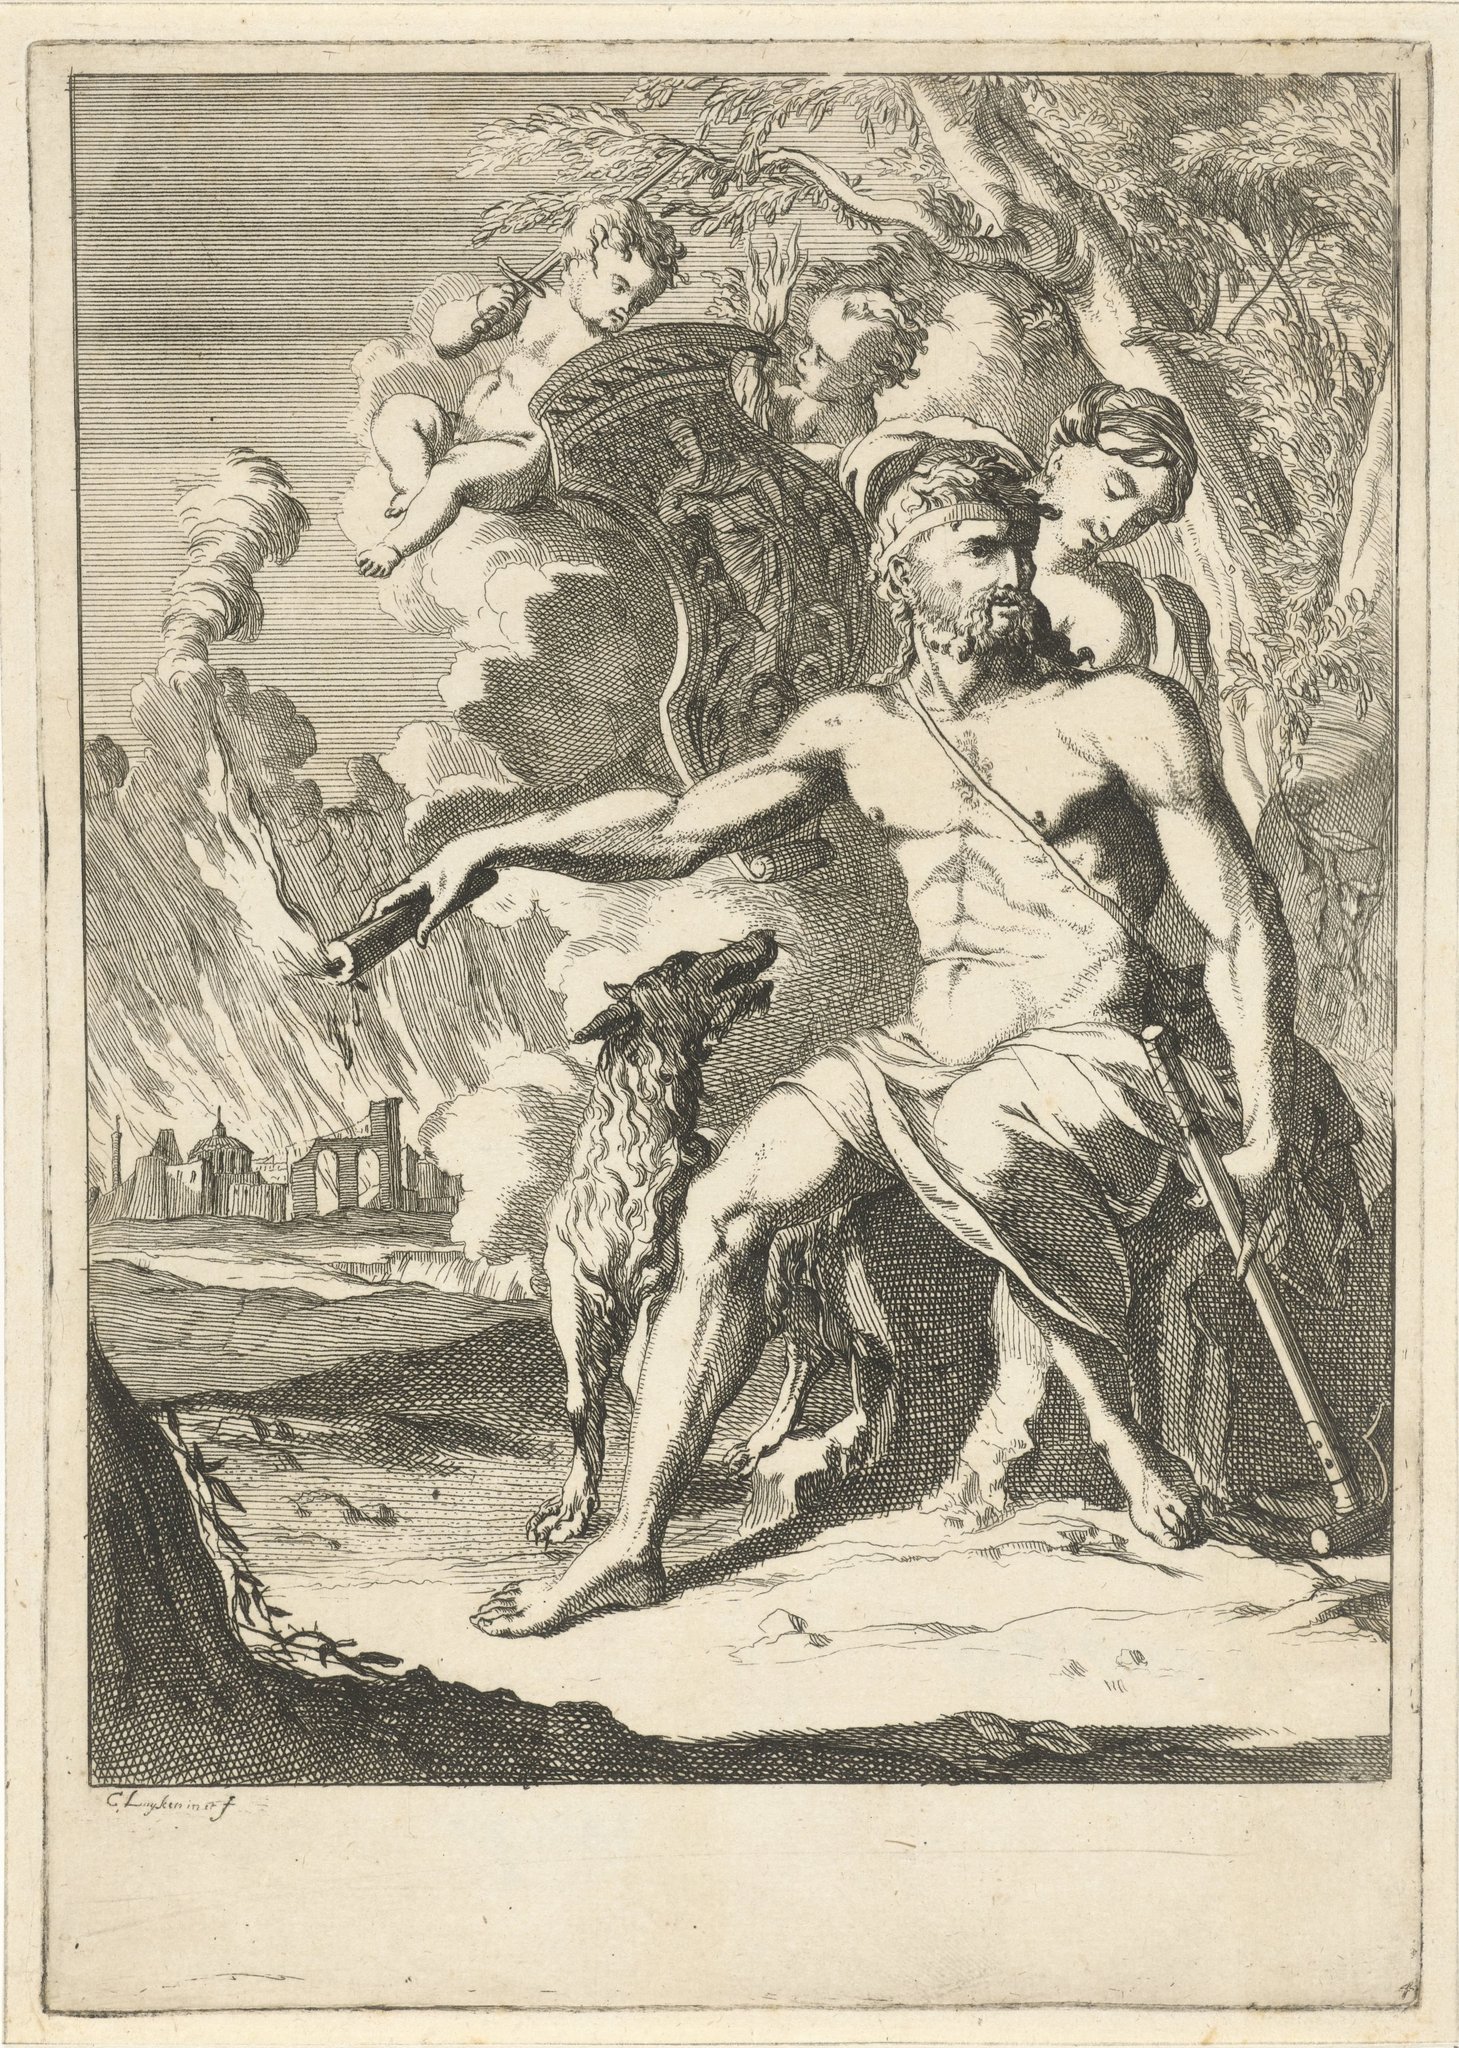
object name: print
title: De vier elementen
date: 1691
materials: paper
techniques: etching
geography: amsterdam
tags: fire (one of the four elements), attributes of mars, beasts of prey, predatory animals: wolf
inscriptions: collector's mark: Lugt 2228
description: Mars, zittend met een brandende toorts en een bijl in zijn handen. Naast hem staat een wolf. Putti brengen Mars zijn zwaard, schild en bliksemschichten.